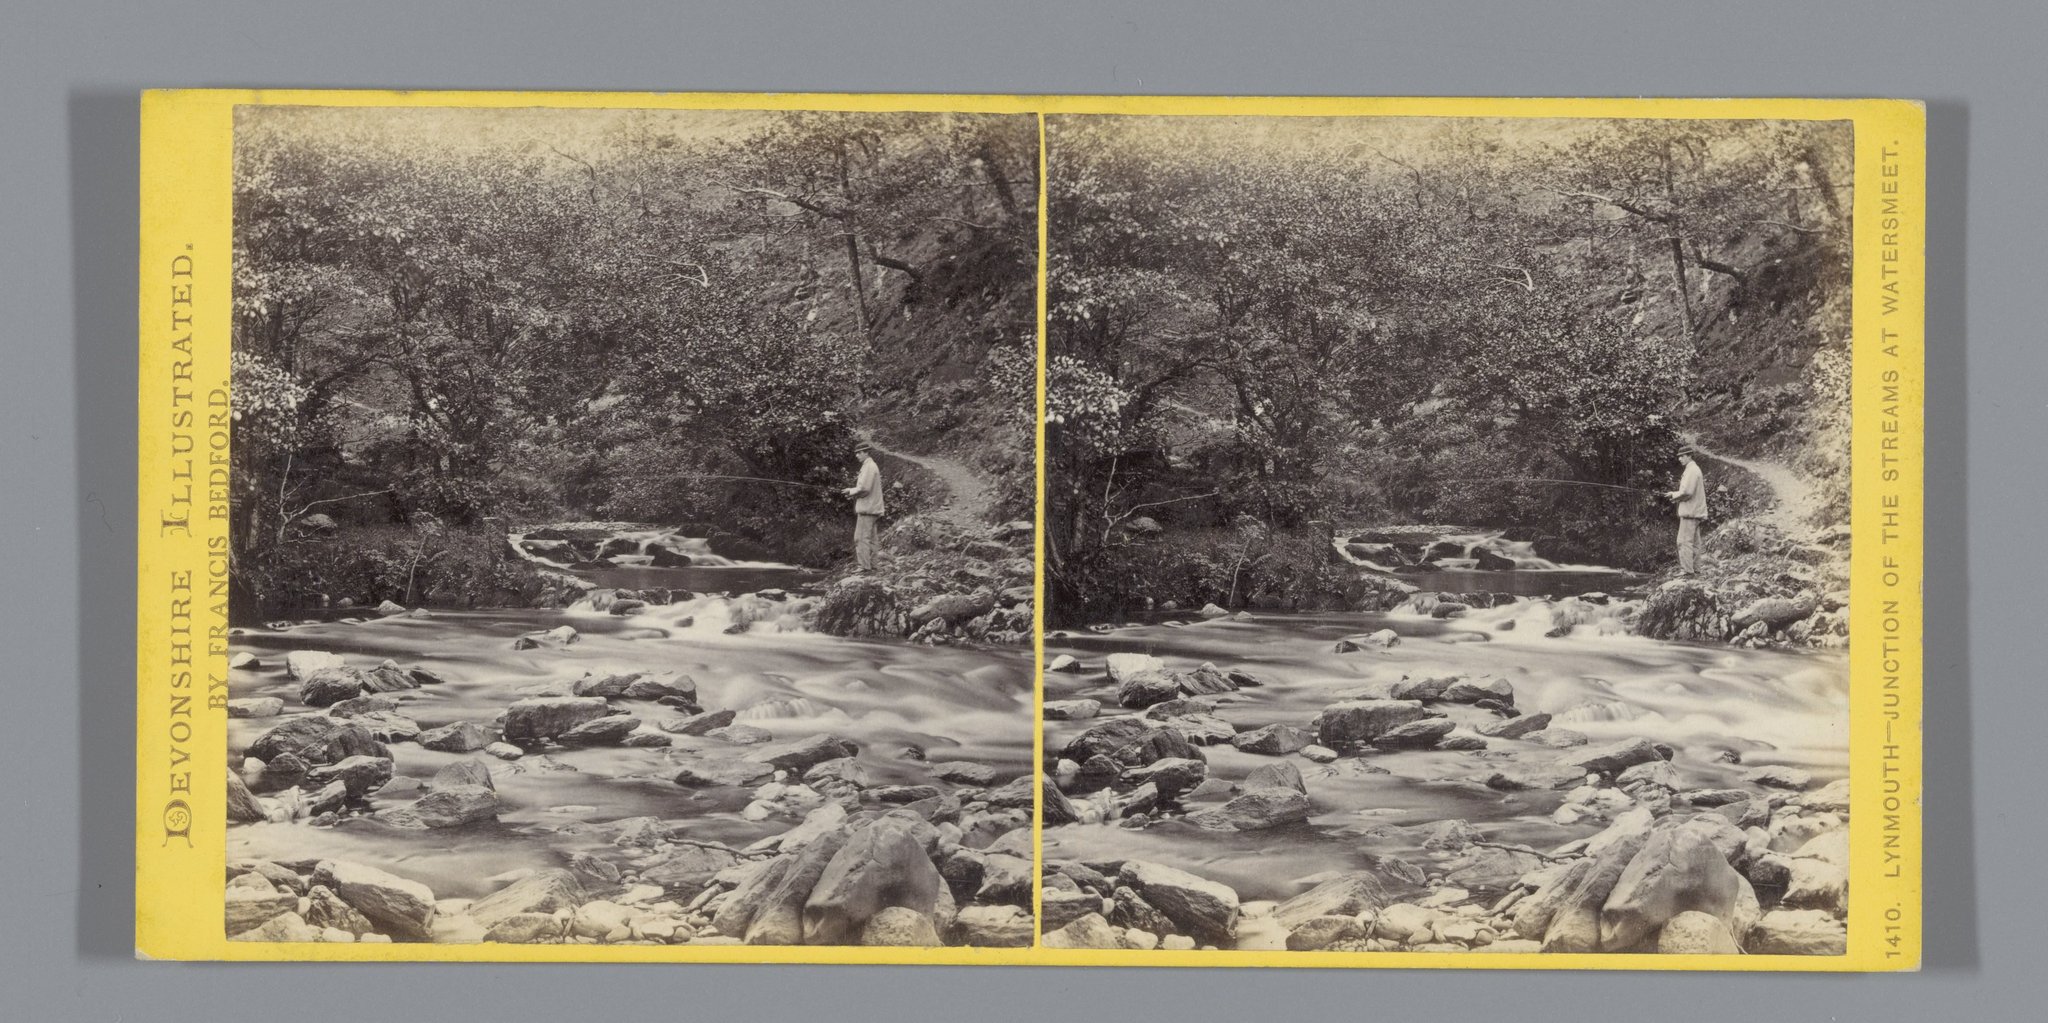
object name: stereograph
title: Stroomversnellingen bij Watersmeet House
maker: francis bedford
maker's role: print maker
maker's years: 1815-1894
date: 1850-1880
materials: cardboard, photographic support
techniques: albumen print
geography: lynmouth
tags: brook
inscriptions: number: ‘1410.’, inscription: ‘Devonshire Illustrated. by Francis Bedford.’